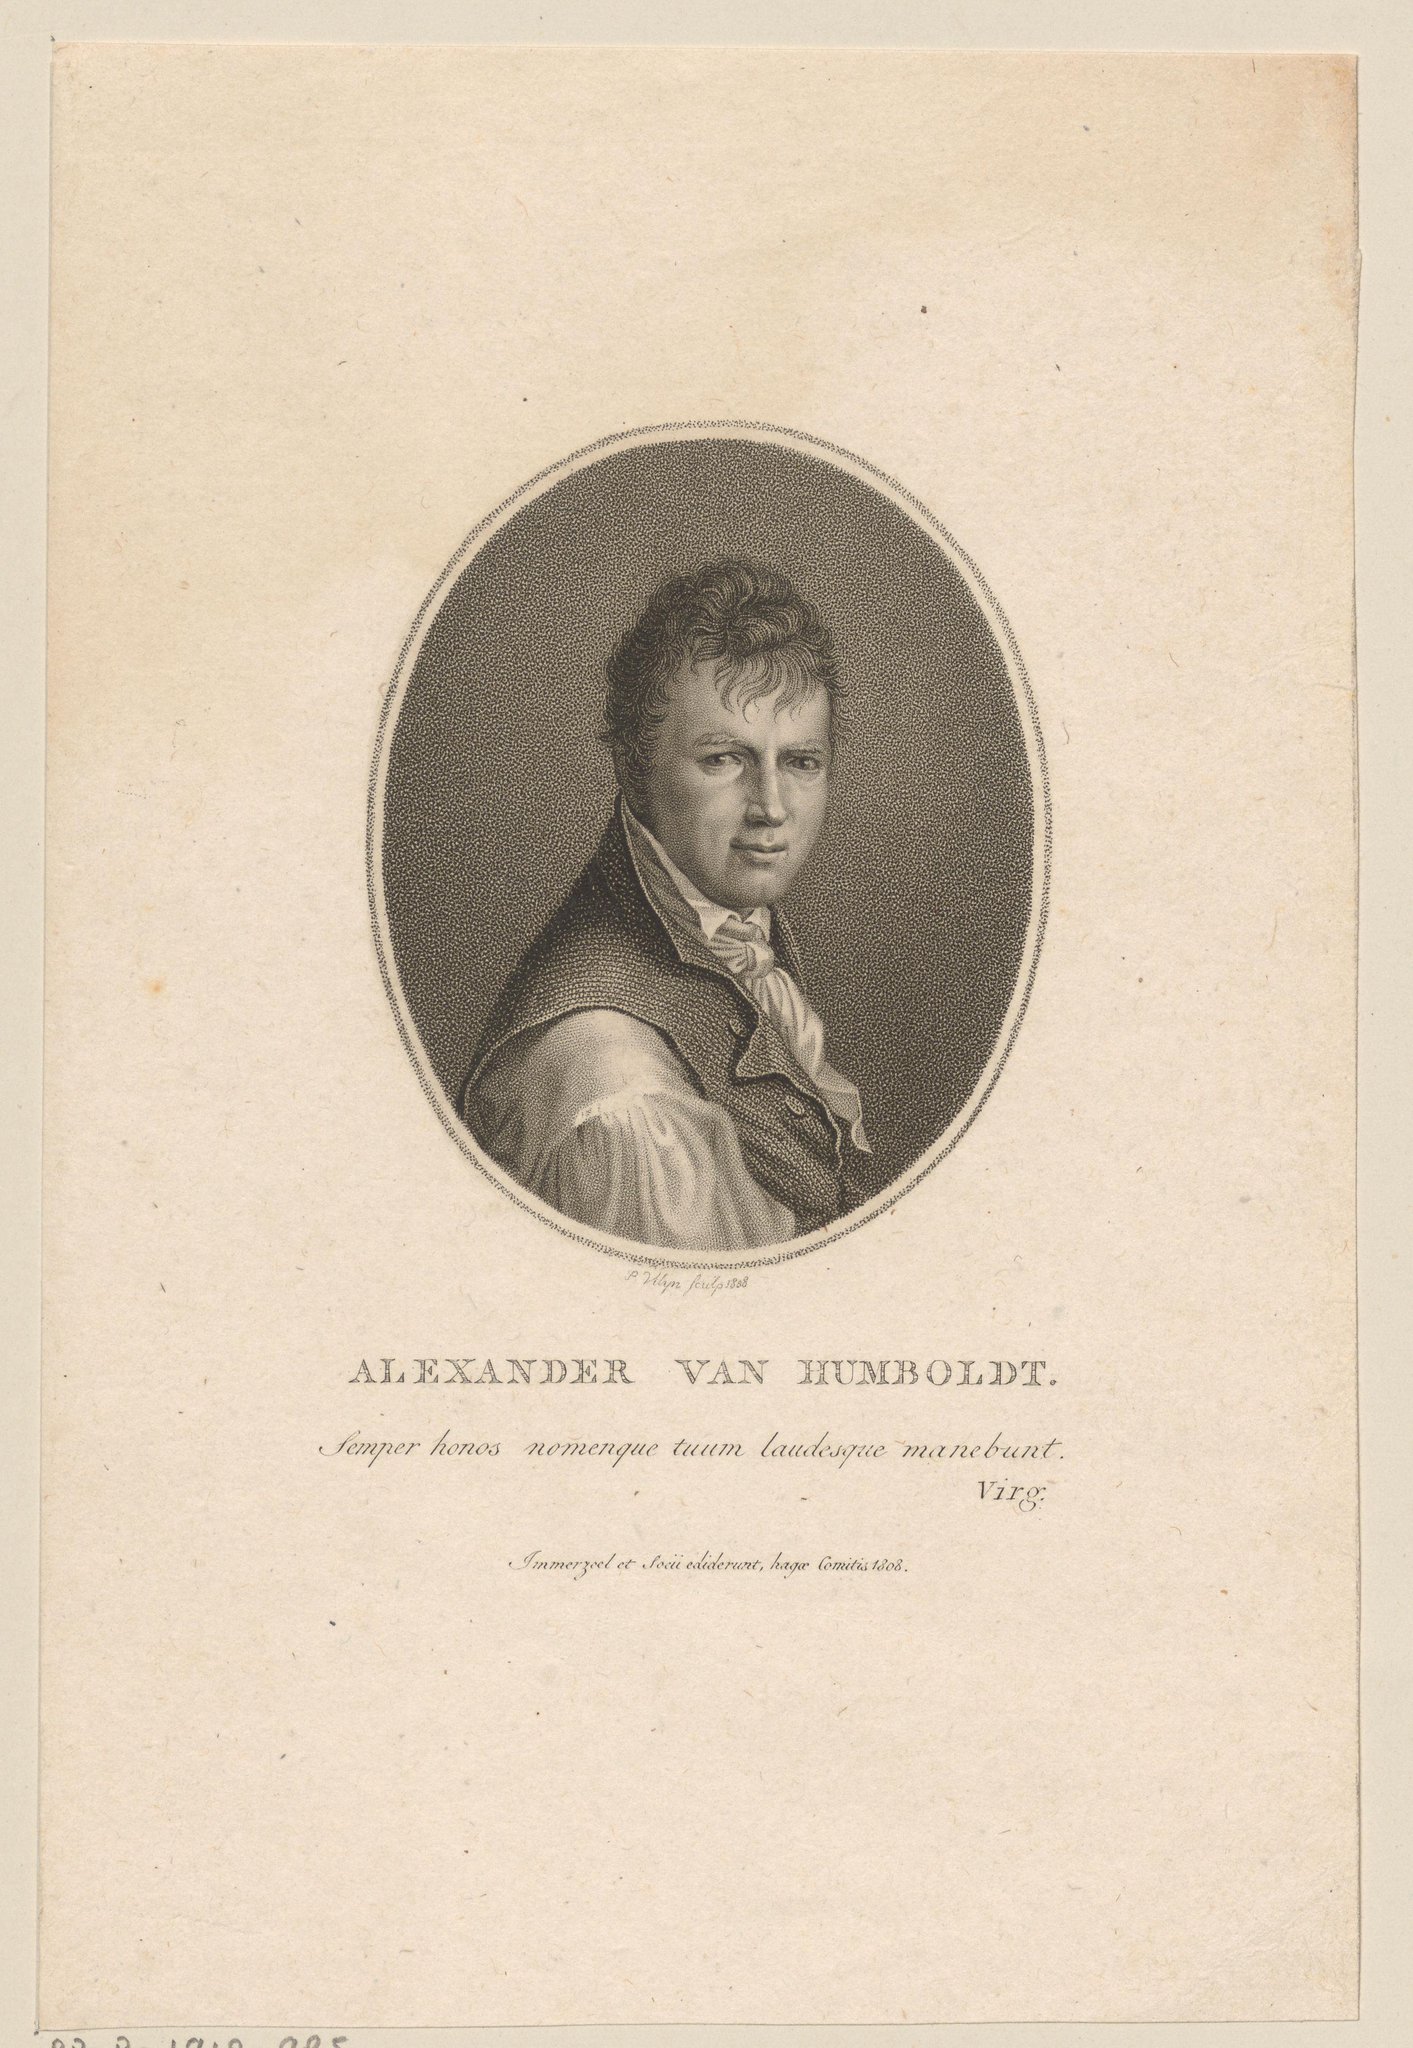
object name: print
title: Portret van Alexander von Humboldt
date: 1808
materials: paper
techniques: engraving, etching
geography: the hague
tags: berlin, traveler, historical persons, biology (+ portrait of scholar, scientist)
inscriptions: collector's mark: Lugt 2233